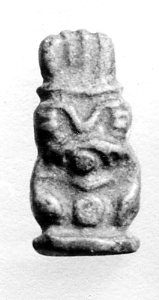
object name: amulet, be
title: Bes amulet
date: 664-332 BCE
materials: faience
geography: egypt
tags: bes